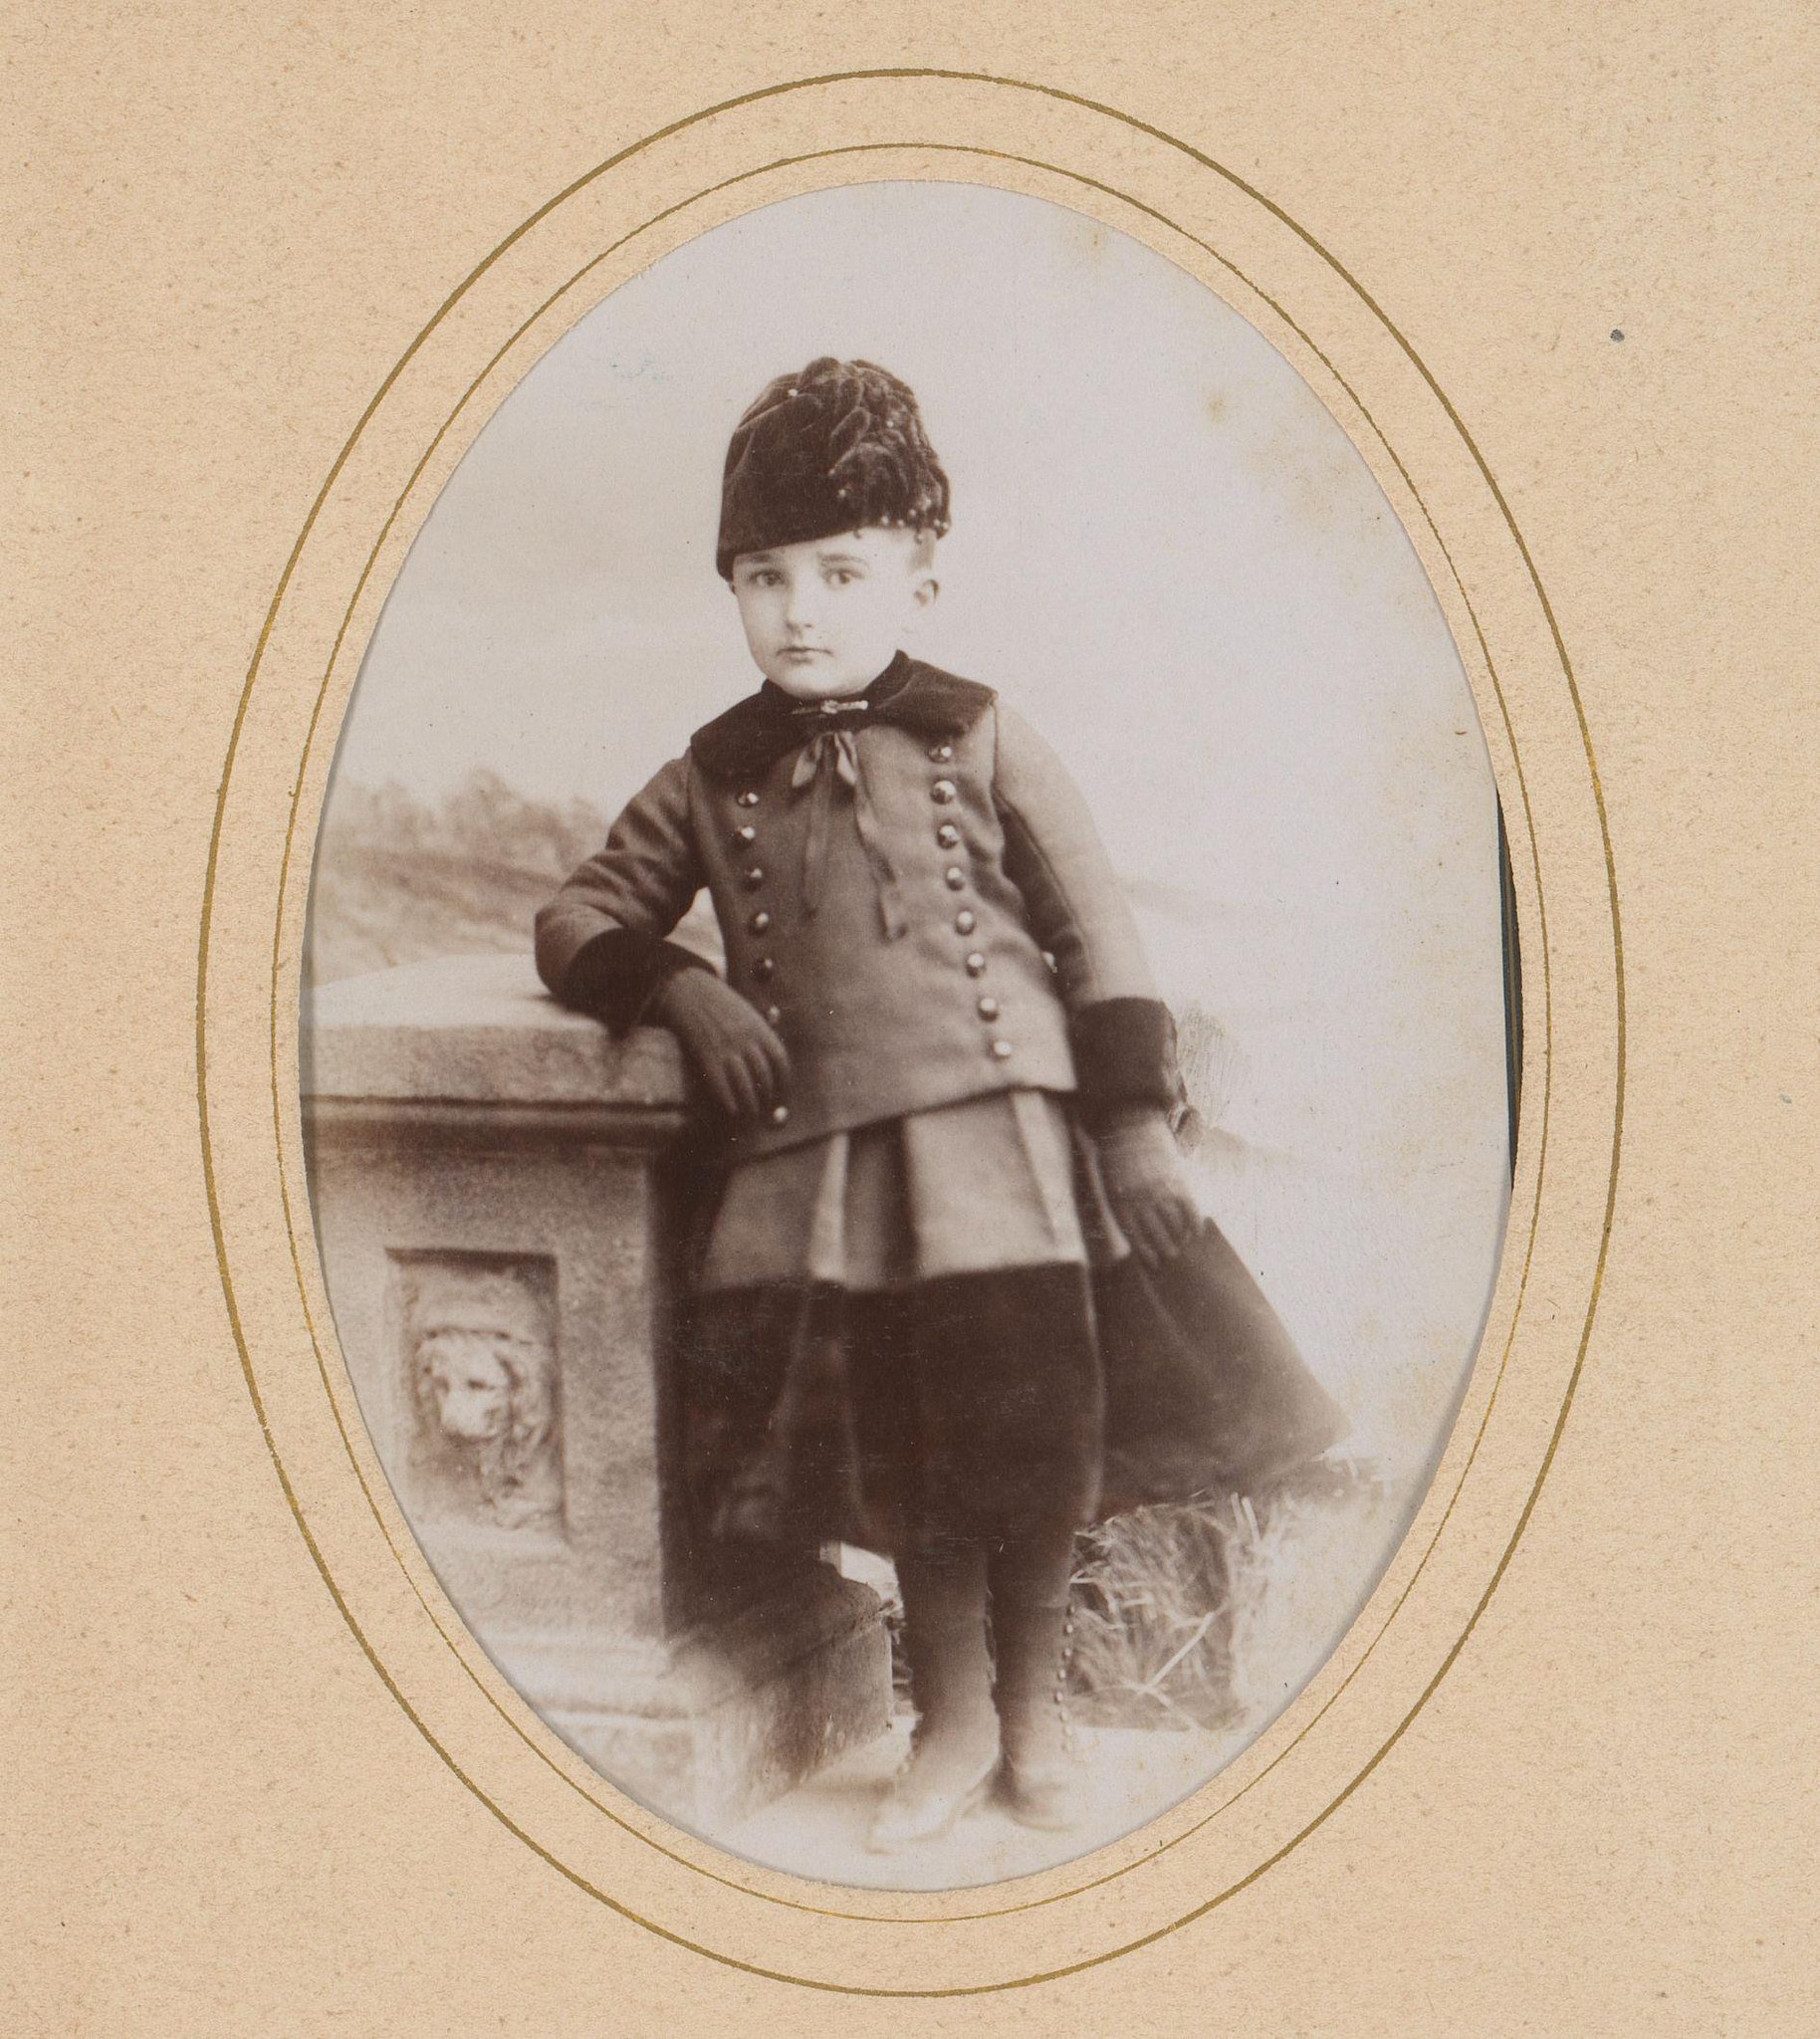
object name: album leaf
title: Portret van een jongen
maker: james u. stead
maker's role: fotograaf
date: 1870-1900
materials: cardboard, photographic support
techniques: albumen print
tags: historical persons, girl (child between toddler and youth)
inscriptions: name: ‘Jas. U. Stead, 383 6th Ave. New York.’